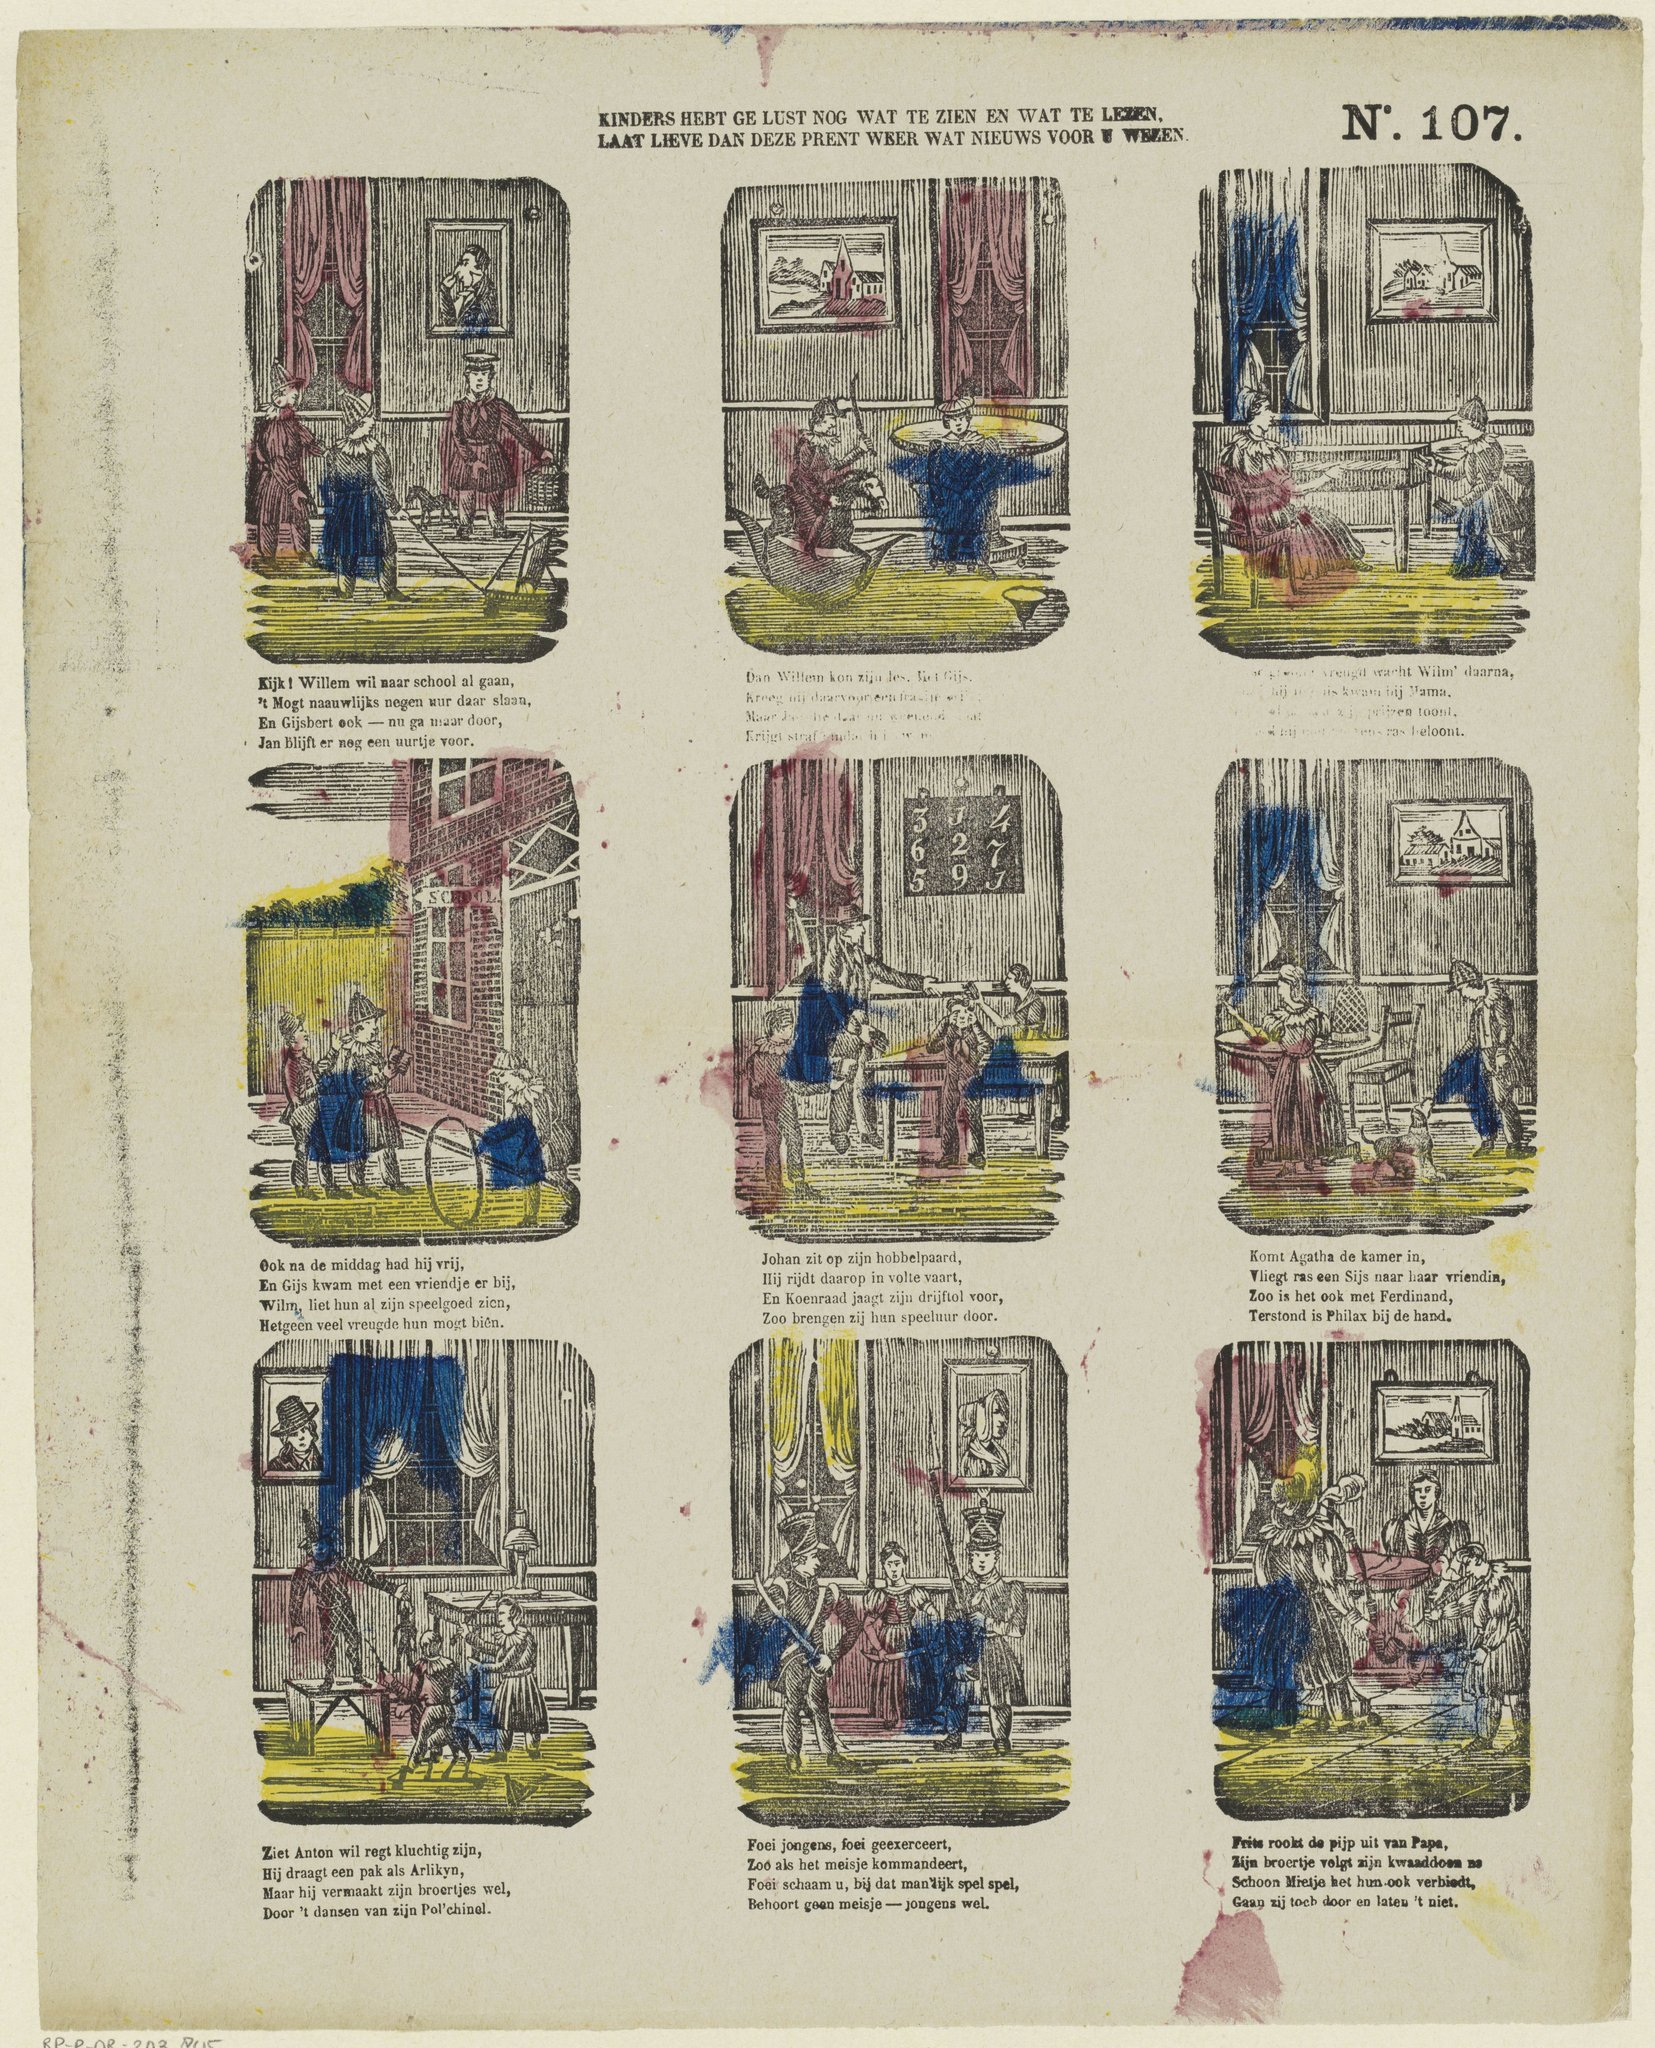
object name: popular print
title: Kinders hebt ge lust nog wat te zien en wat te lezen, / Laat lieve dan deze prent weer wat nieuws voor u wezen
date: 1827-1894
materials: paper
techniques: colour, letterpress printing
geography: schaarbeek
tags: children's games and plays, games using special objects (marbles, top, hoop, etc.), rocking-horse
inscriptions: collector's mark: Lugt 2760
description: Blad met 9 voorstellingen van kinderspelen, zoals hobbelpaardje rijden, hoepelen en soldaatje spelen. Onder elke afbeelding een vierregelig vers. Genummerd rechtsboven: No. 107.